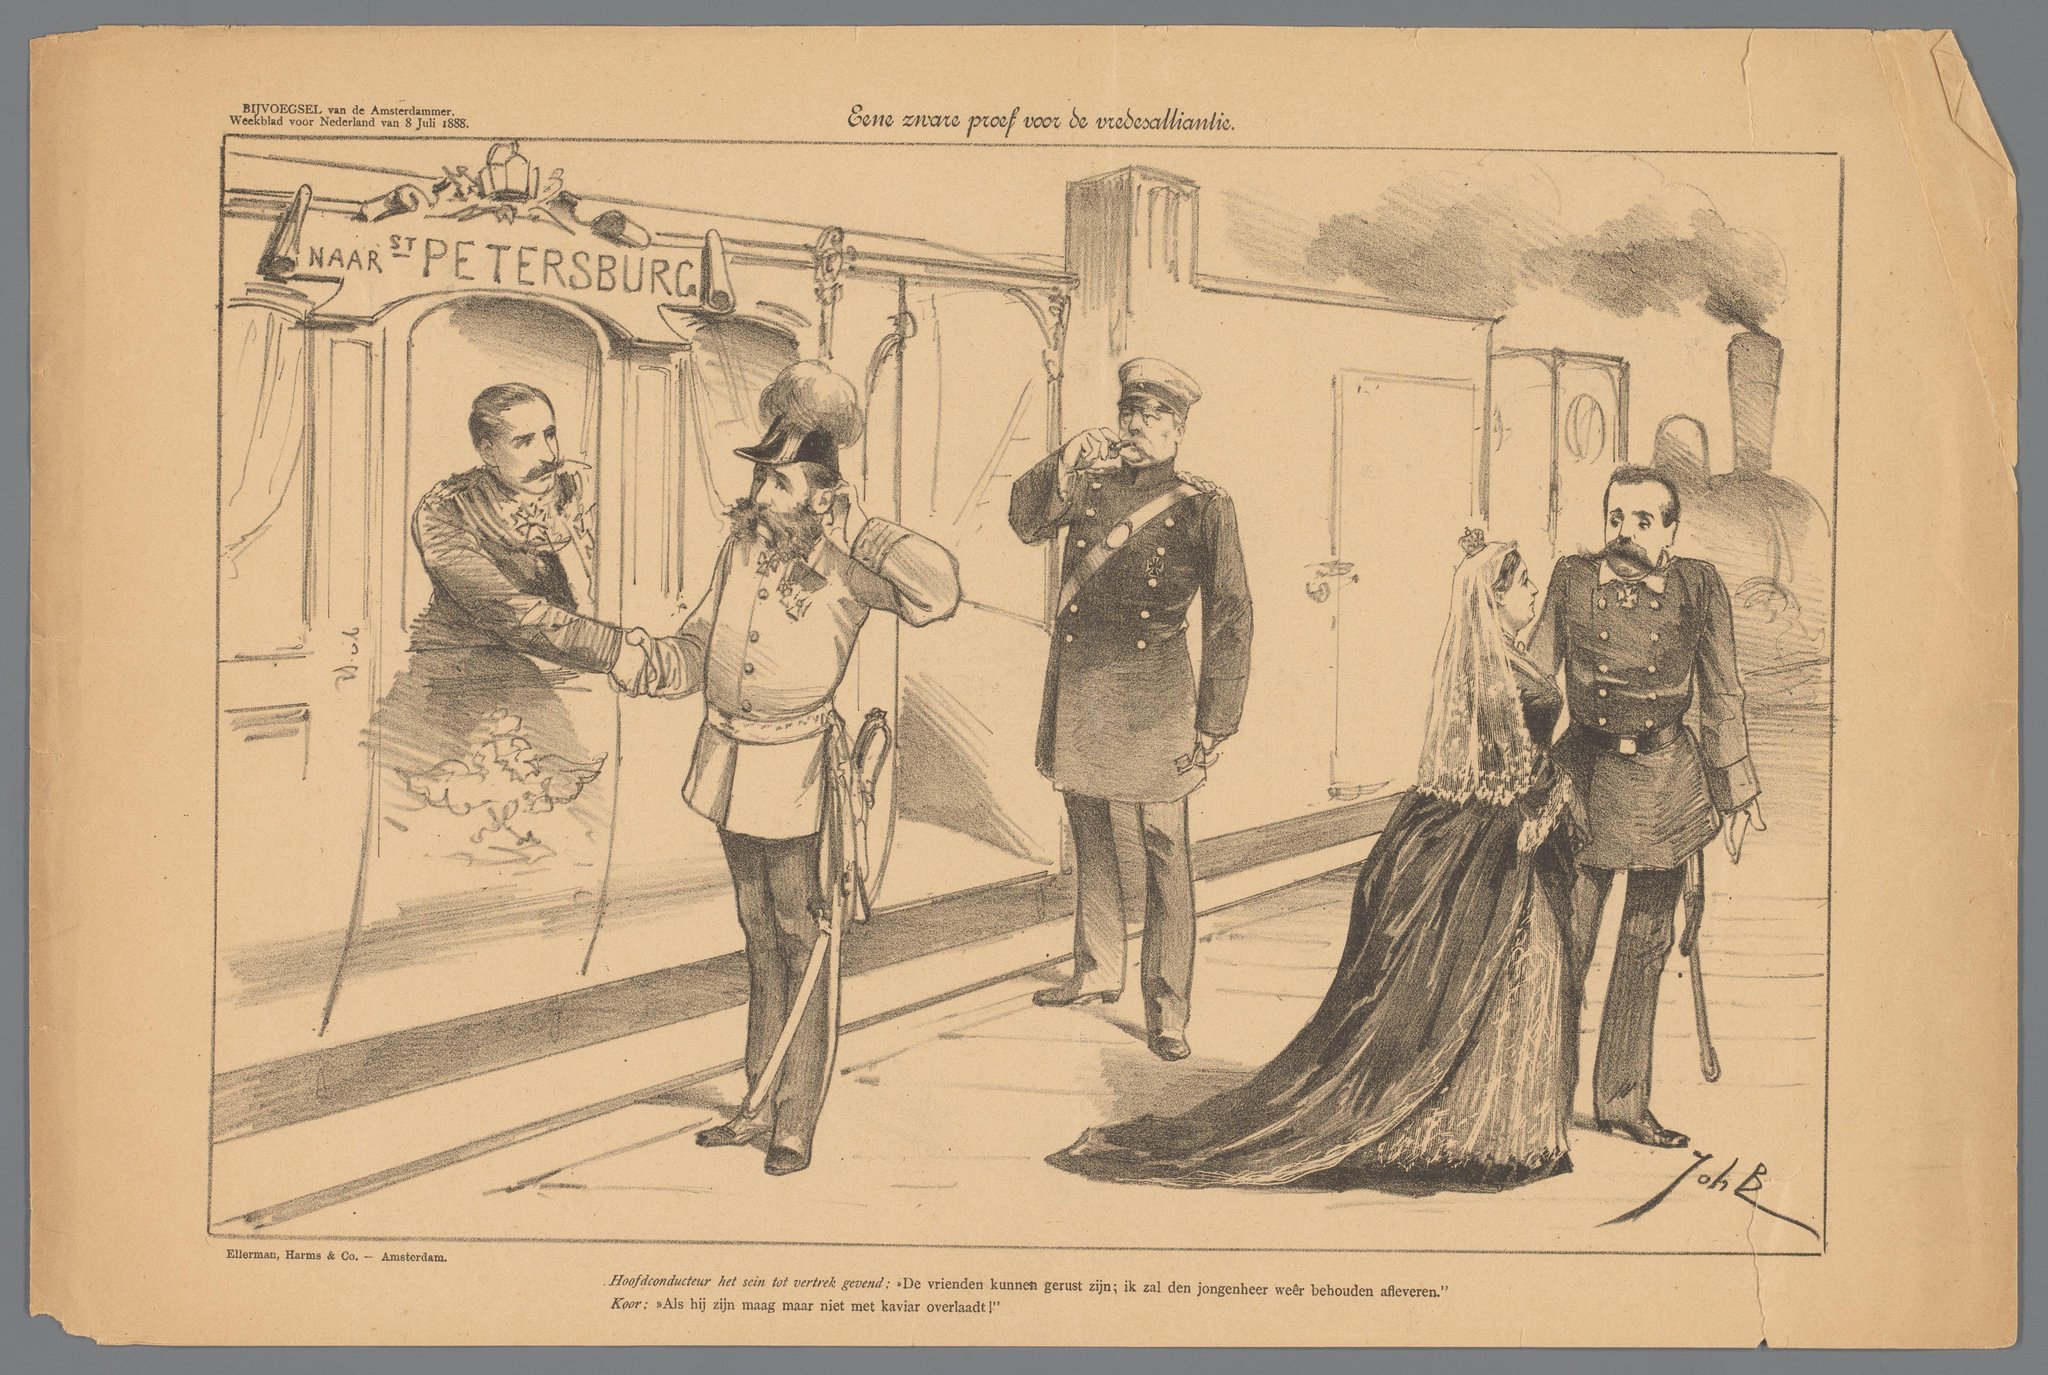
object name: print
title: Spotprent van figuren op het perron bij een trein naar Sint-Petersburg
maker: johan braakensiek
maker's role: draughtsman, print maker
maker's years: 1858-1940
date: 1888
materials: paper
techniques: lithograph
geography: amsterdam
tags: ruler, sovereign, steam locomotive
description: Prent als bijvoegsel bij: De Amsterdammer 12 (1888), nr. 576, 8 juli 1888.